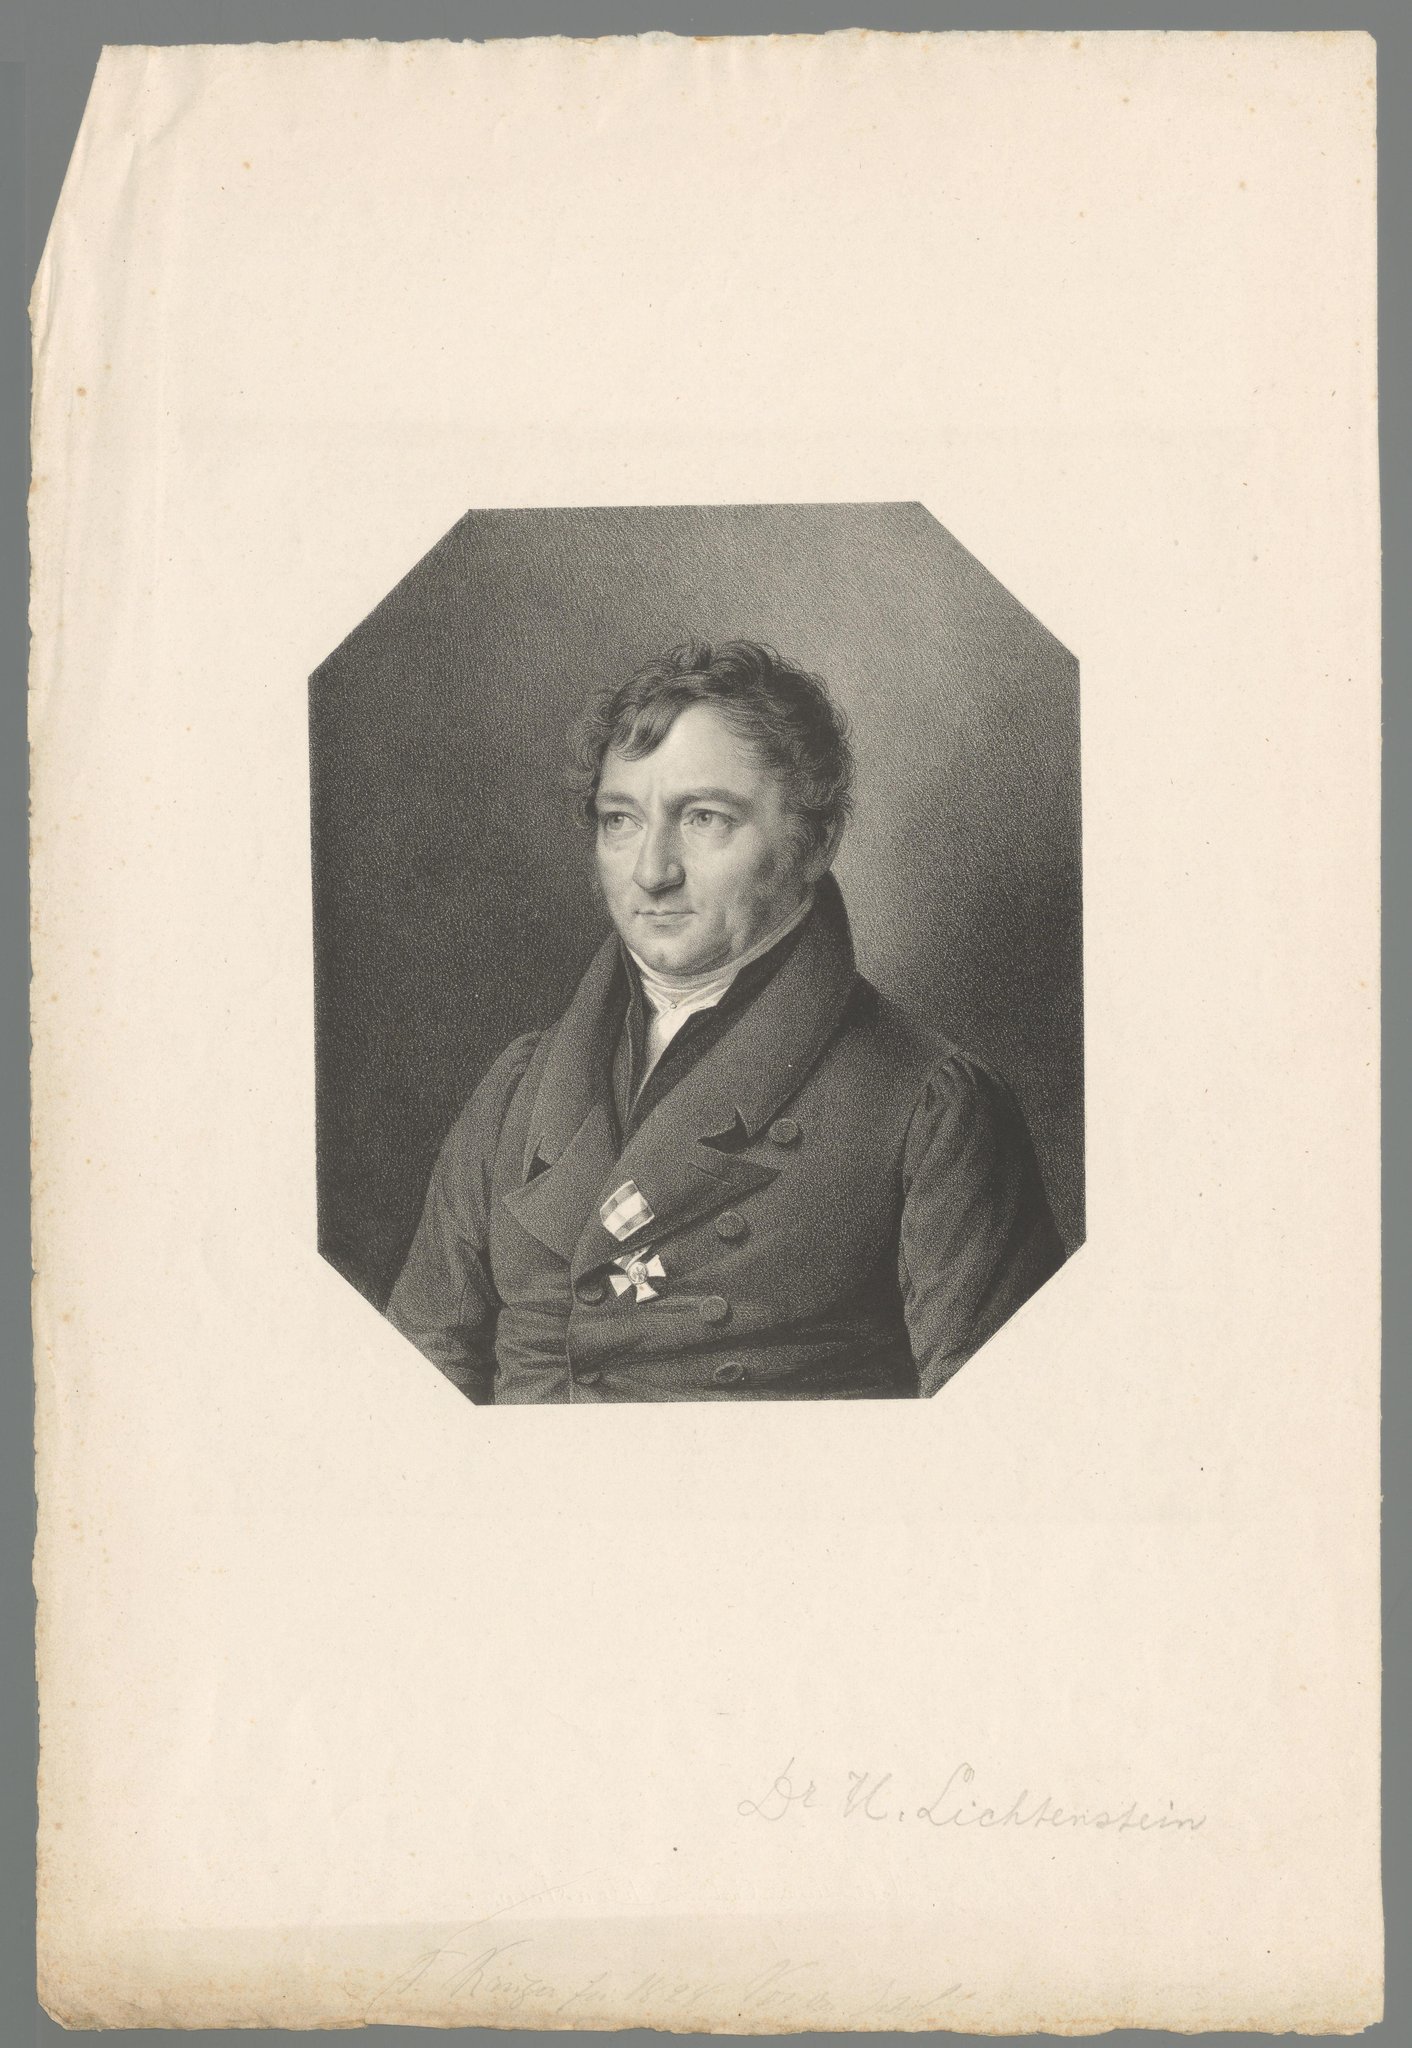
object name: print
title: Portret van Martin Hinrich Lichtenstein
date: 1828-1837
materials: paper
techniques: lithograph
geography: berlin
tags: historical persons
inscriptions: collector's mark: Lugt 2228, inscription: ‘Mart. Heinr. Carl Lichtenstein./ 1828.’